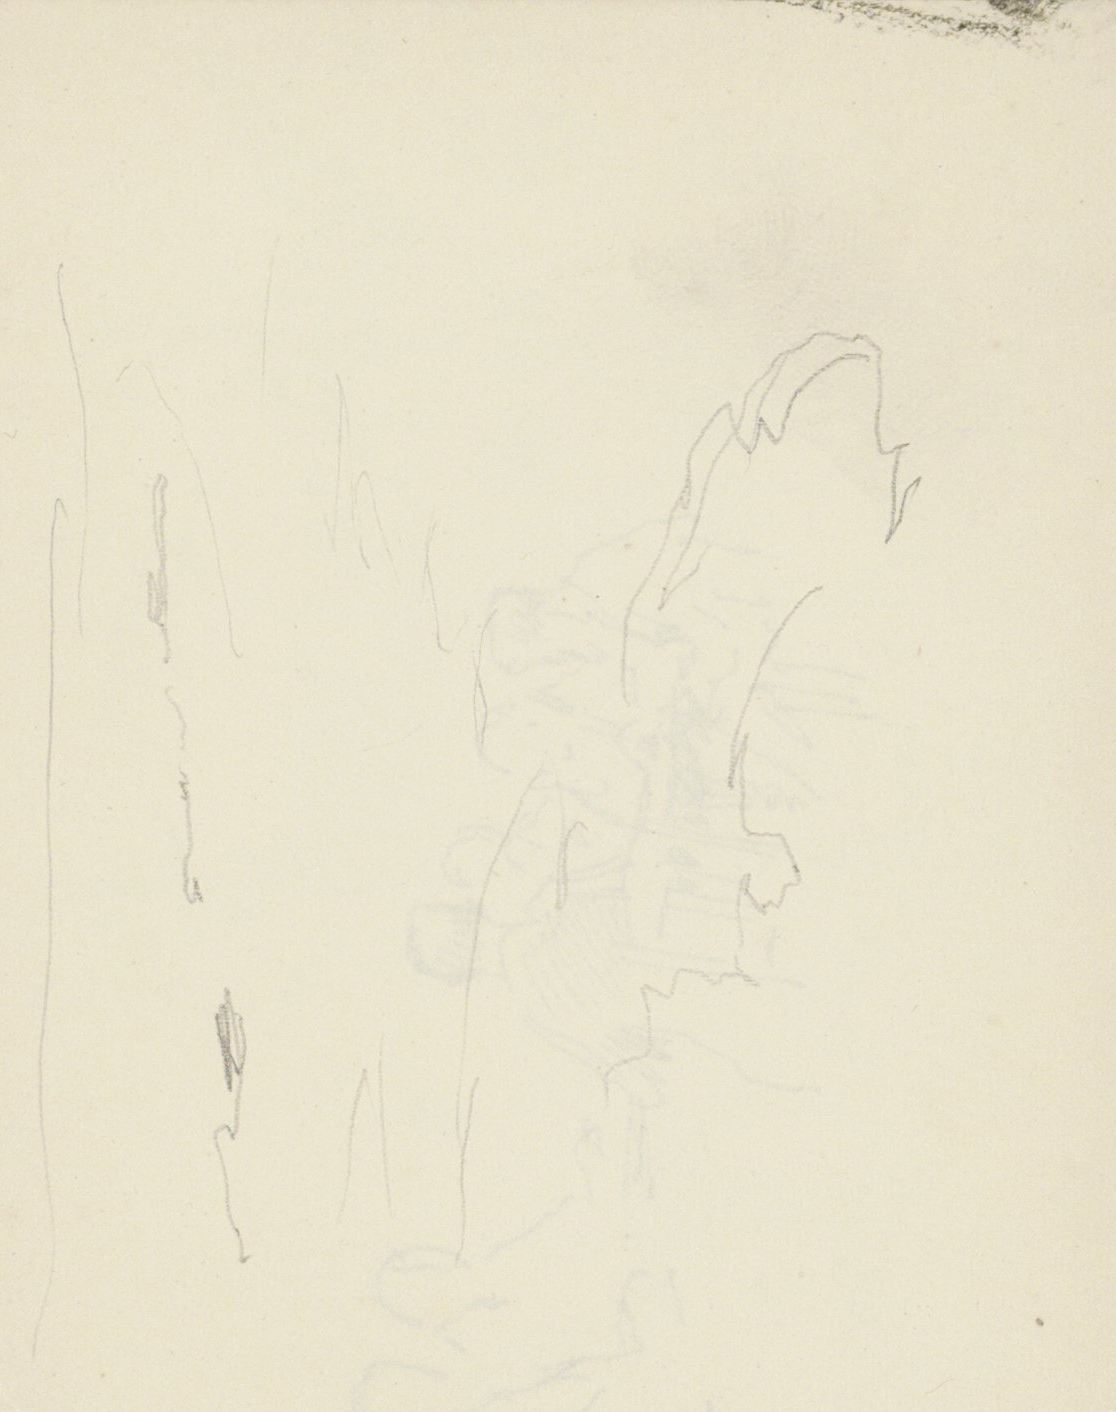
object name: sketchbook leaf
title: Studie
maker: cornelis vreedenburgh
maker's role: draughtsman, print maker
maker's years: 1880-1946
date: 1890-1946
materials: paper, pencil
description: Blad 41 recto uit een schetsboek met 71 bladen.